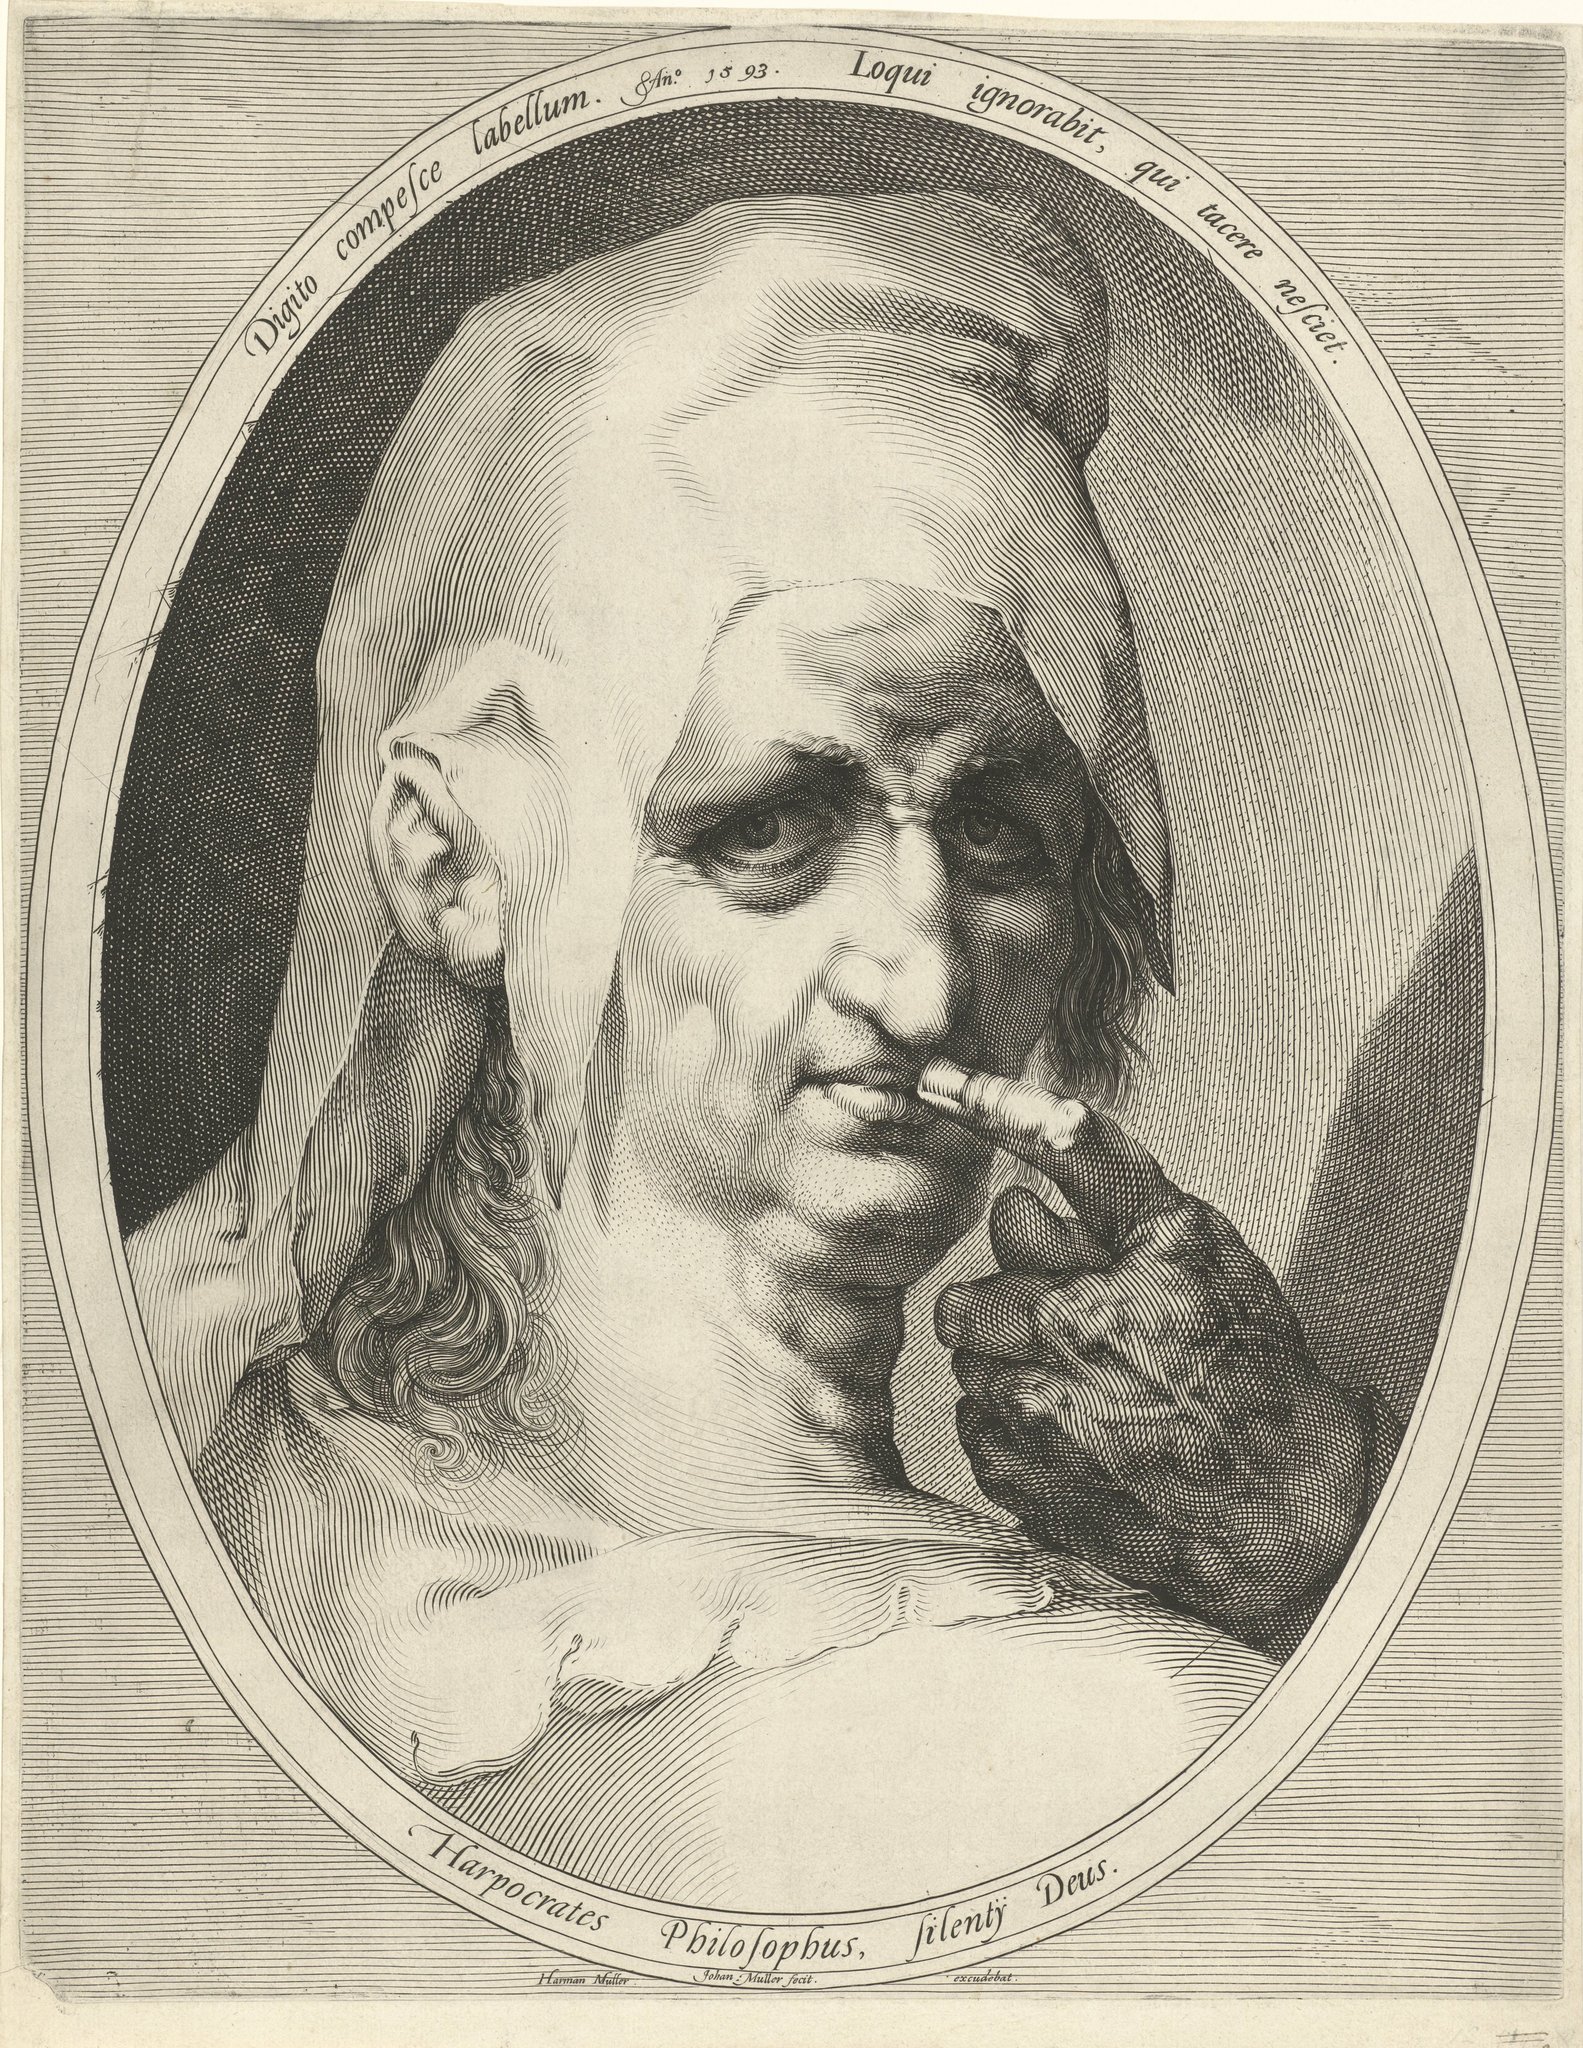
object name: print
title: Harpocrates, Philosophus, Silentii Deus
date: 1593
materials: paper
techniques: engraving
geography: amsterdam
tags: putting a finger to the lips, 'silentium'; 'silentio' (ripa), harpocrates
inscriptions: collector's mark: Lugt 240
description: Harpocrates, de god van de stilte, houdt zijn vinger tegen zijn lippen.